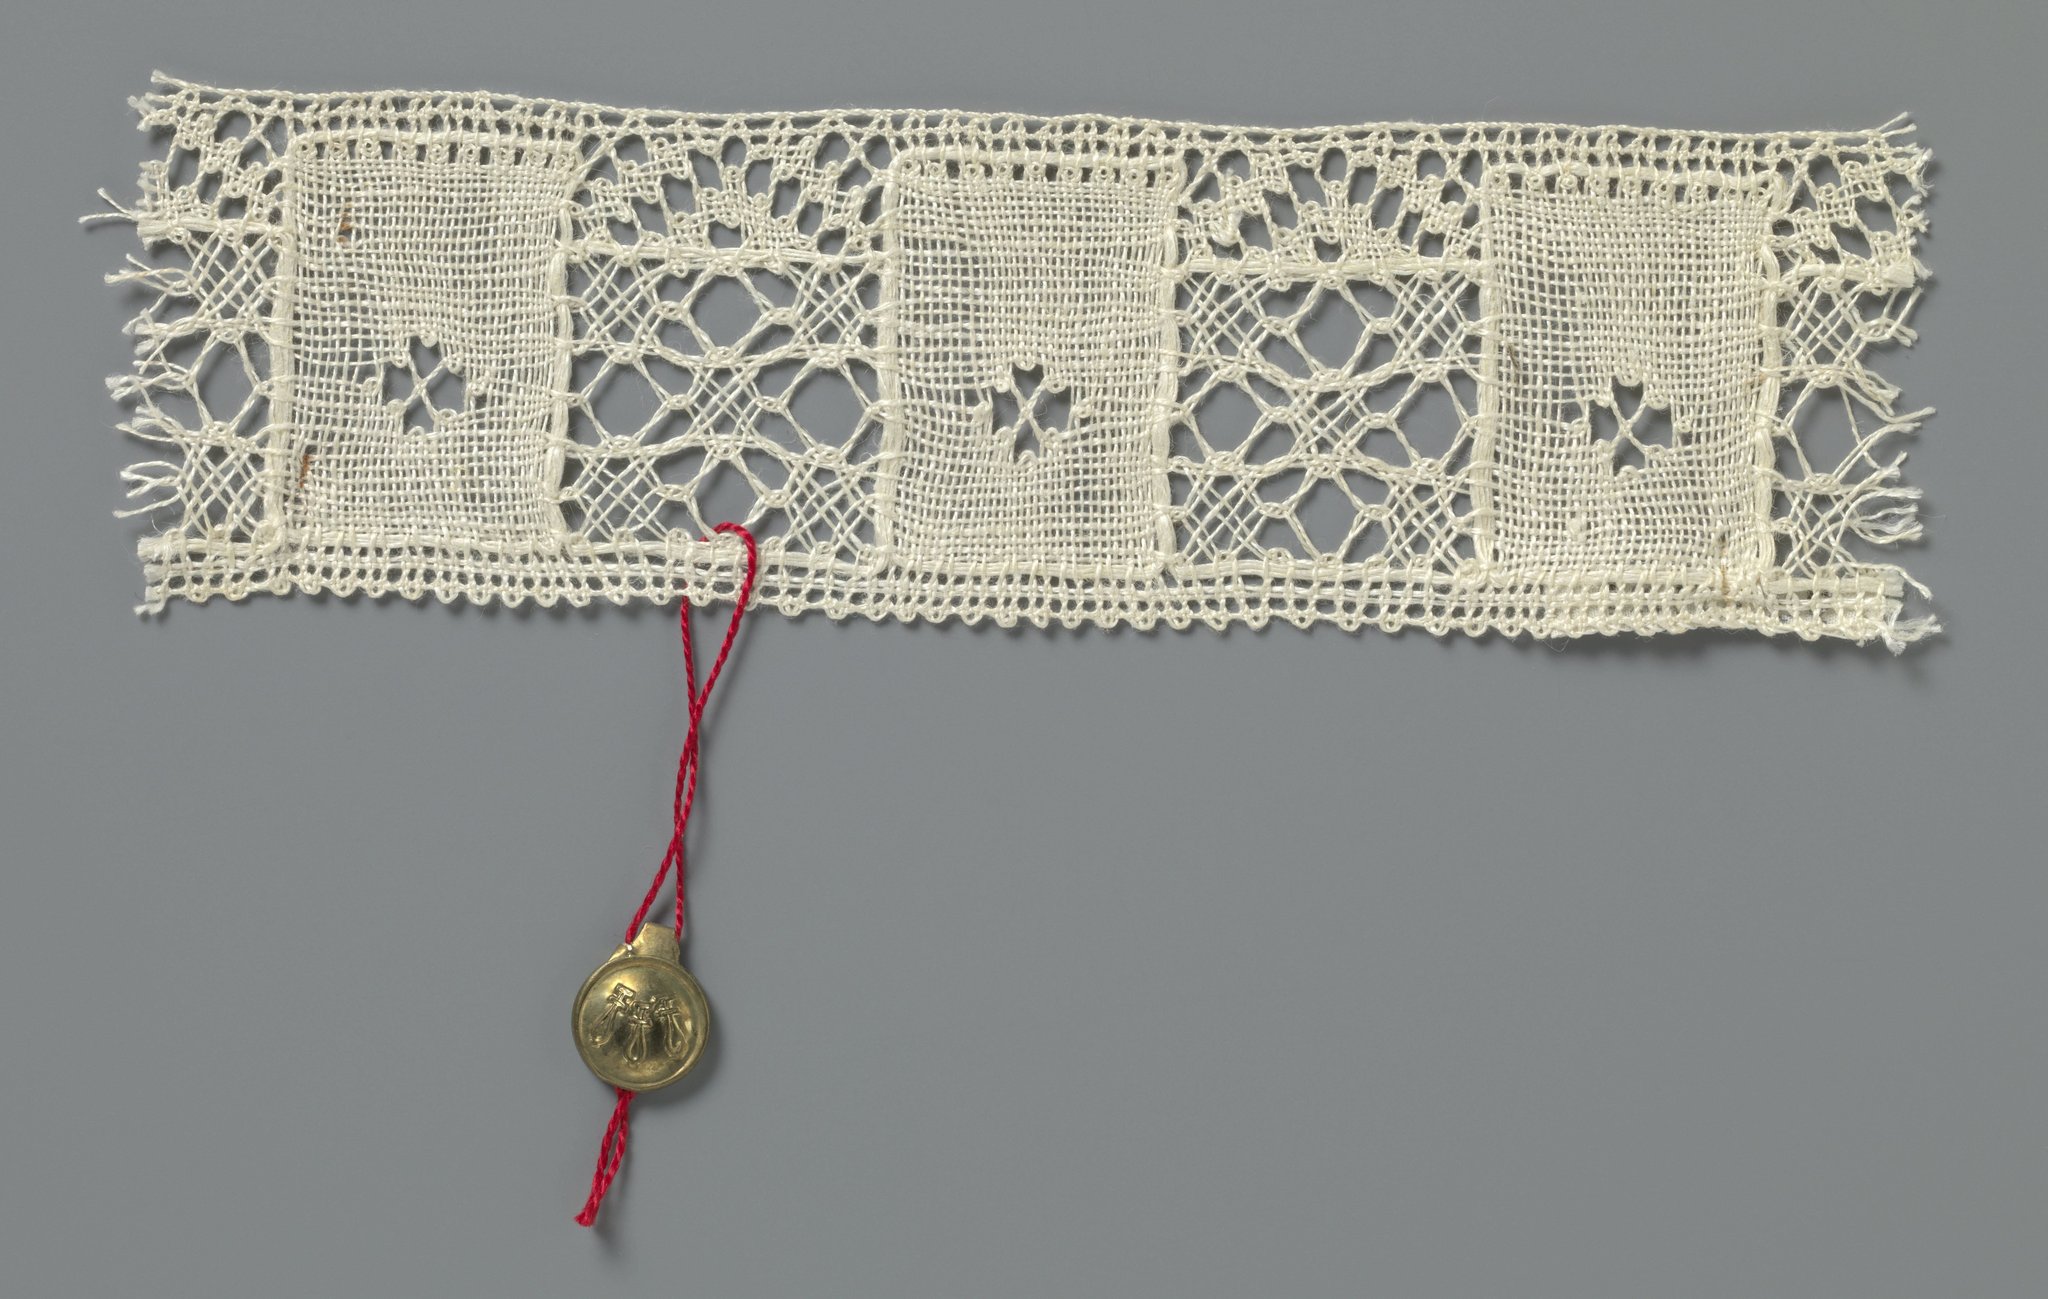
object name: strip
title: Strook kloskant met kerkraam of "Kyrkfönster"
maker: Anonymous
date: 1800-1899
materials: linen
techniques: lace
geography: vadstena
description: Strook naturelkleurige kant, Zweedse kant. De strook is met spelden op een lichtblauw karton bevestigd, met vier andere stroken. Bovenaan het karton staat "Wadstena. Sweden. " geschreven en onder de strook staat "Church windows. (Kyrkfönster.)". Het zich herhalende patroon bestaat uit twee staande rechthoeken. De ene rechthoek is gemaakt in linnenslag met een rozetvormige uitsparing. De andere rechthoek is gevuld met een siergrond met een patroon waarin een ruitvormige rozet is gemaakt met daarboven twee zigzag-boogjes in linnenslag, die door overstekende paren met elkaar zijn verbonden. Om de rechthoeken lopen contouren gemaakt met draadbundels. De boven- en onderzijde van de strook zijn recht afgewerkt. Aan de strook hangt een rood draadje met een goudkleurig zegel waarop aan de ene kant drie klosjes staan afgebeeld en aan de andere zijde een monogram met een V en een Ö (Vadstena Östergötland?).